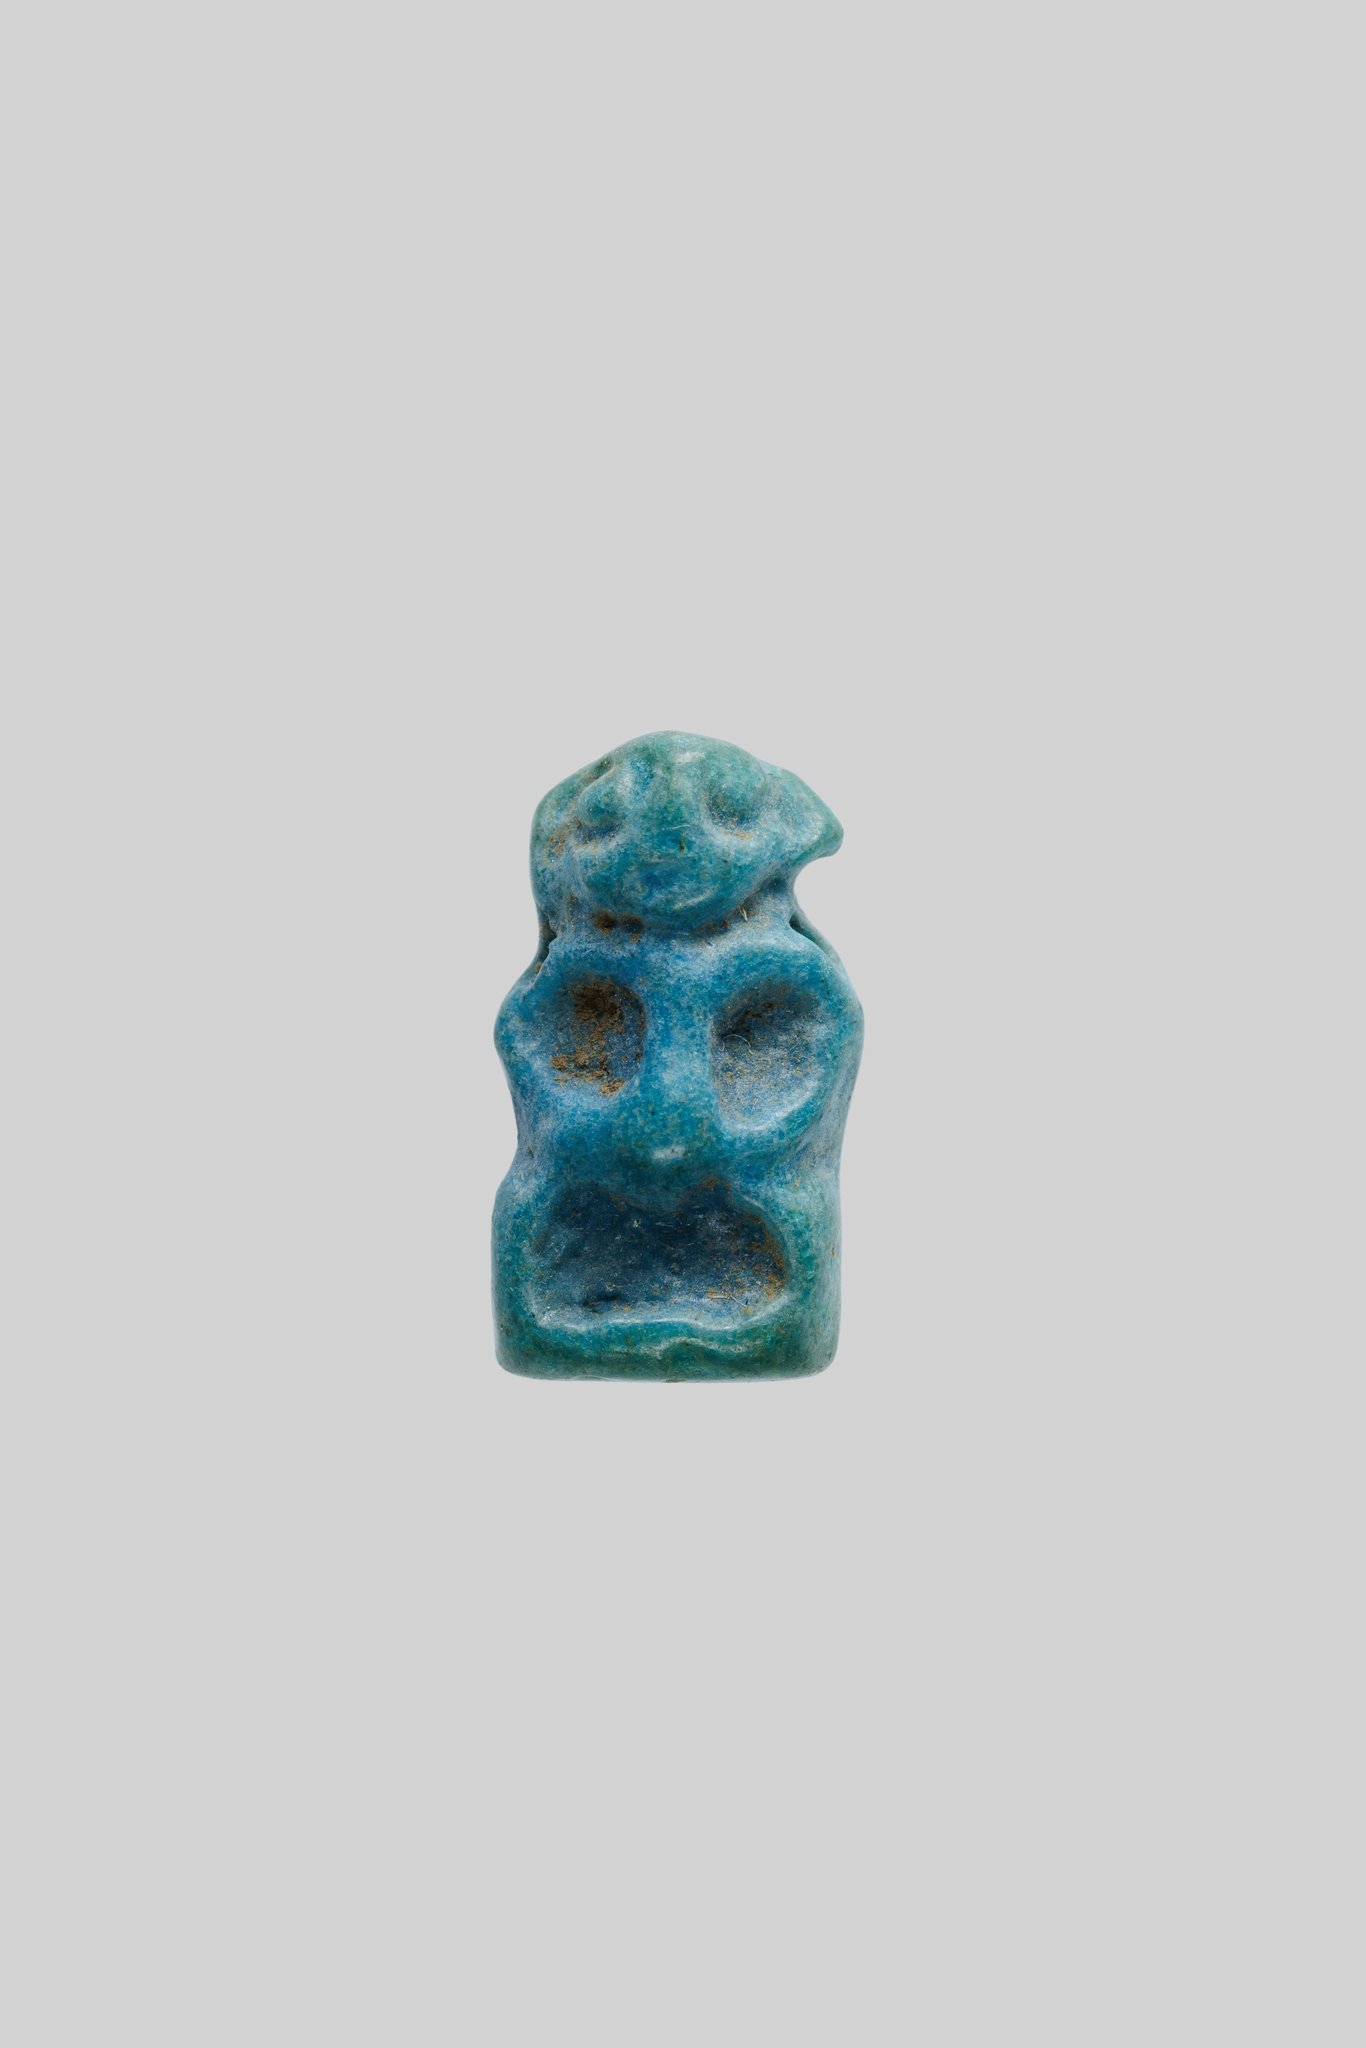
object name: amulet, pataikos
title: Pataikos Amulet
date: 1295-1070 BCE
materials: faience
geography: egypt